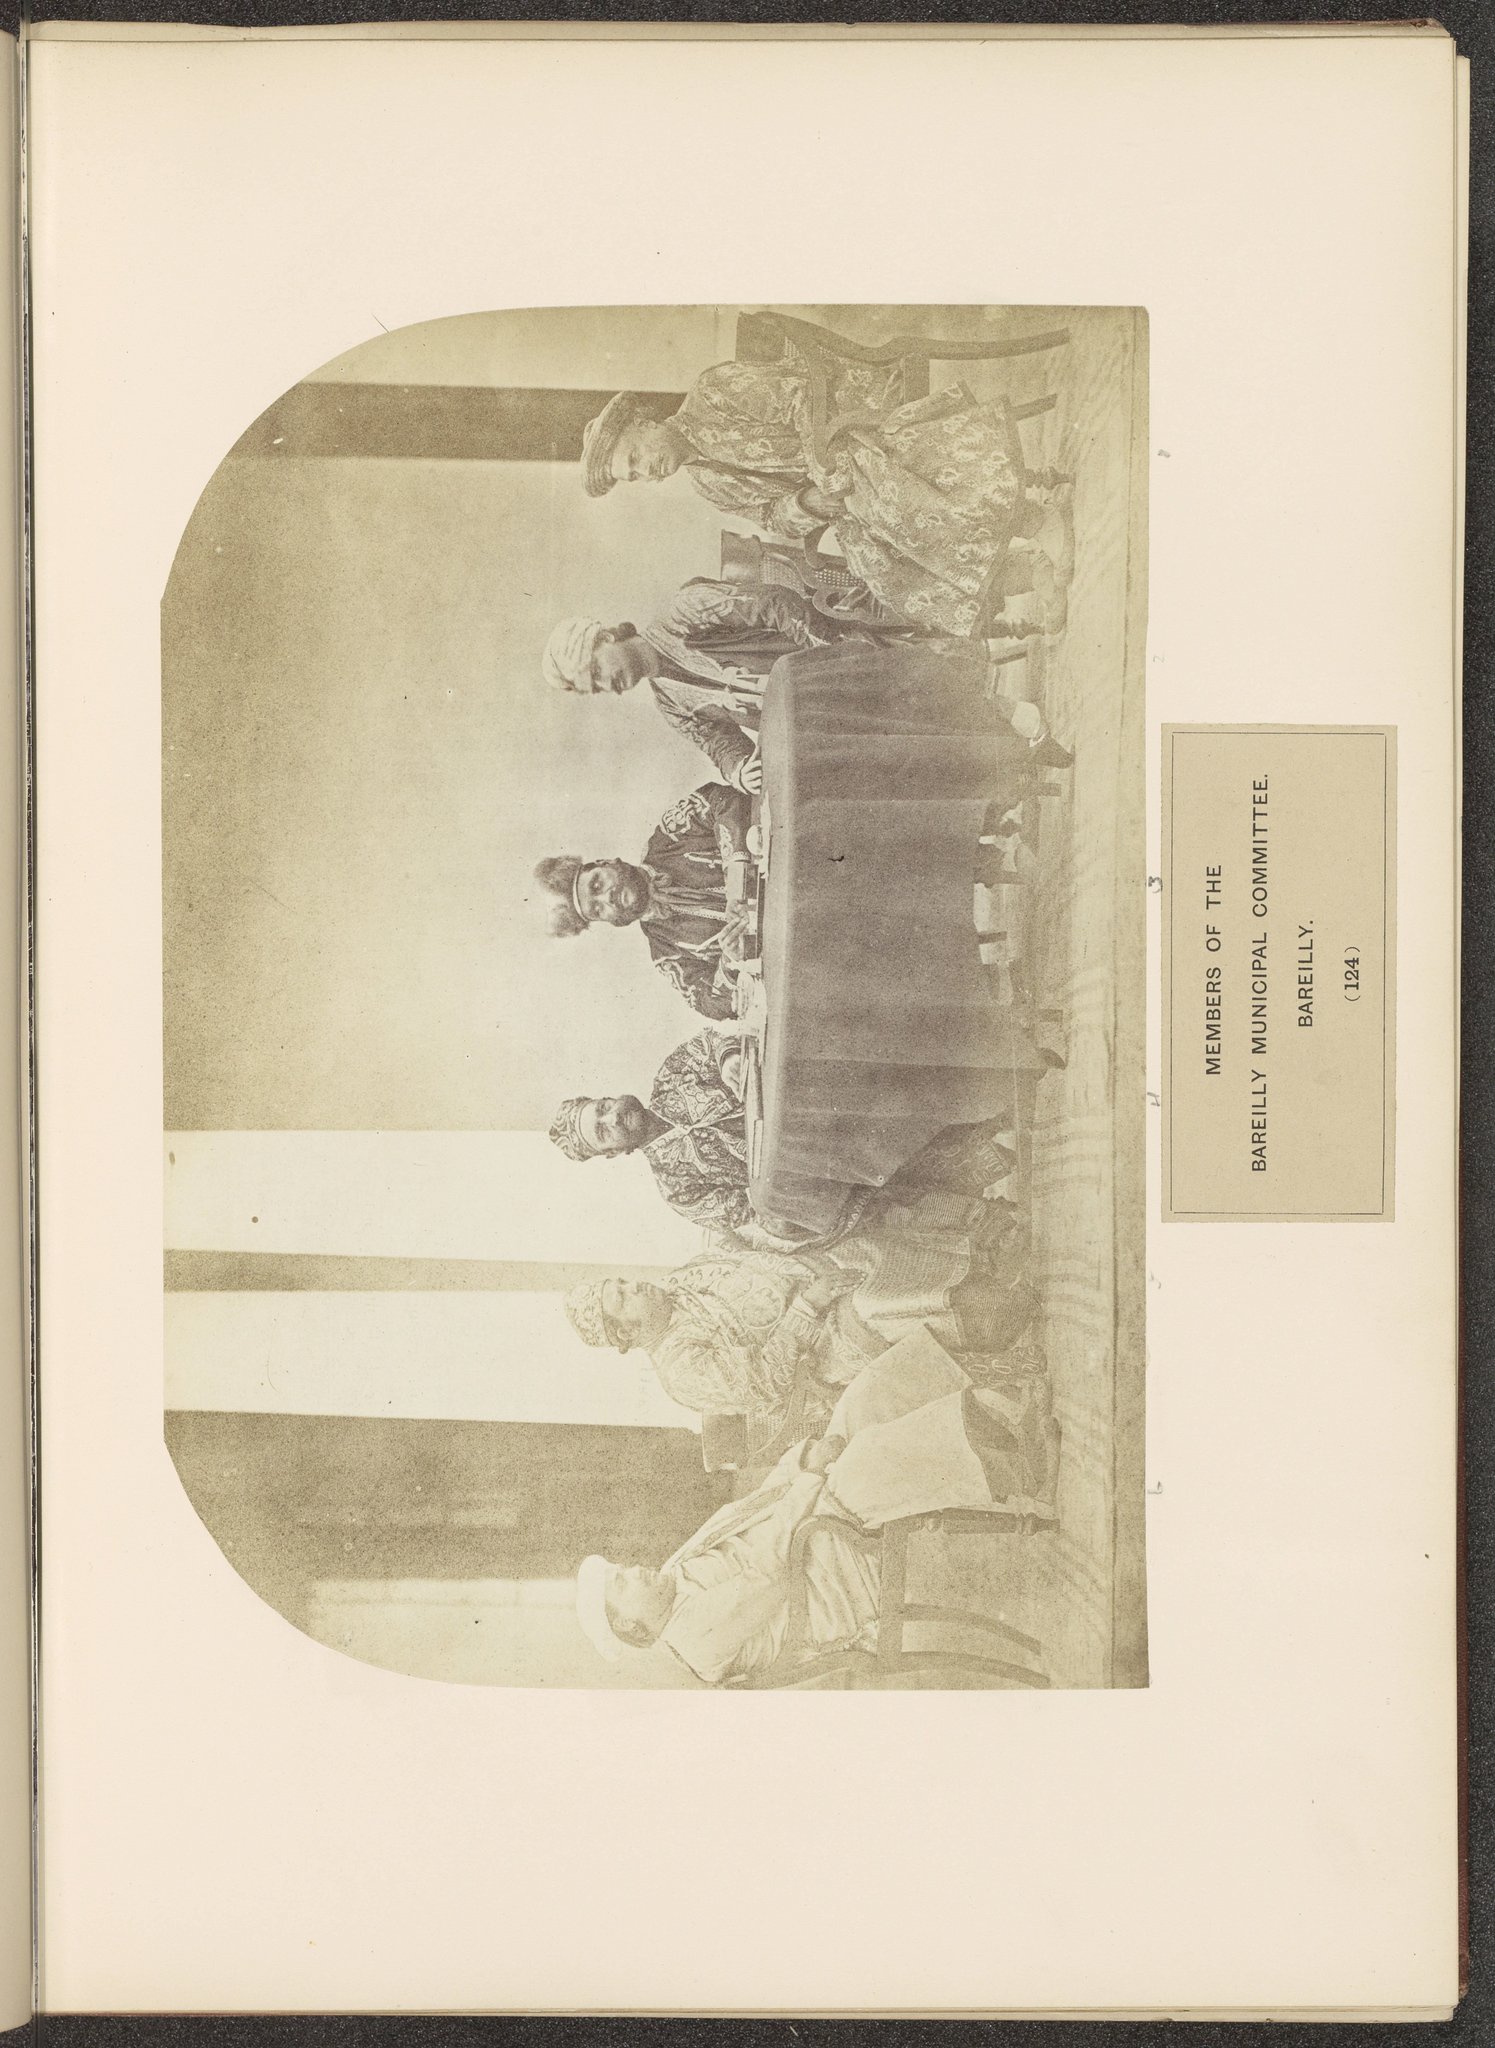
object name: photograph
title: Portrait of six members of the municipal committee of Bareilly, Uttar Pradesh, India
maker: Anonymous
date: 1858-1868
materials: photographic support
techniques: albumen print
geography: bareilly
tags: human races; peoples; nationalities, committee members, board members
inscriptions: inscription: ‘MEMBERS OF THE/ BAREILLY MUNICIPAL COMMITTEE./ BAREILLY.’, number: ‘(124)’